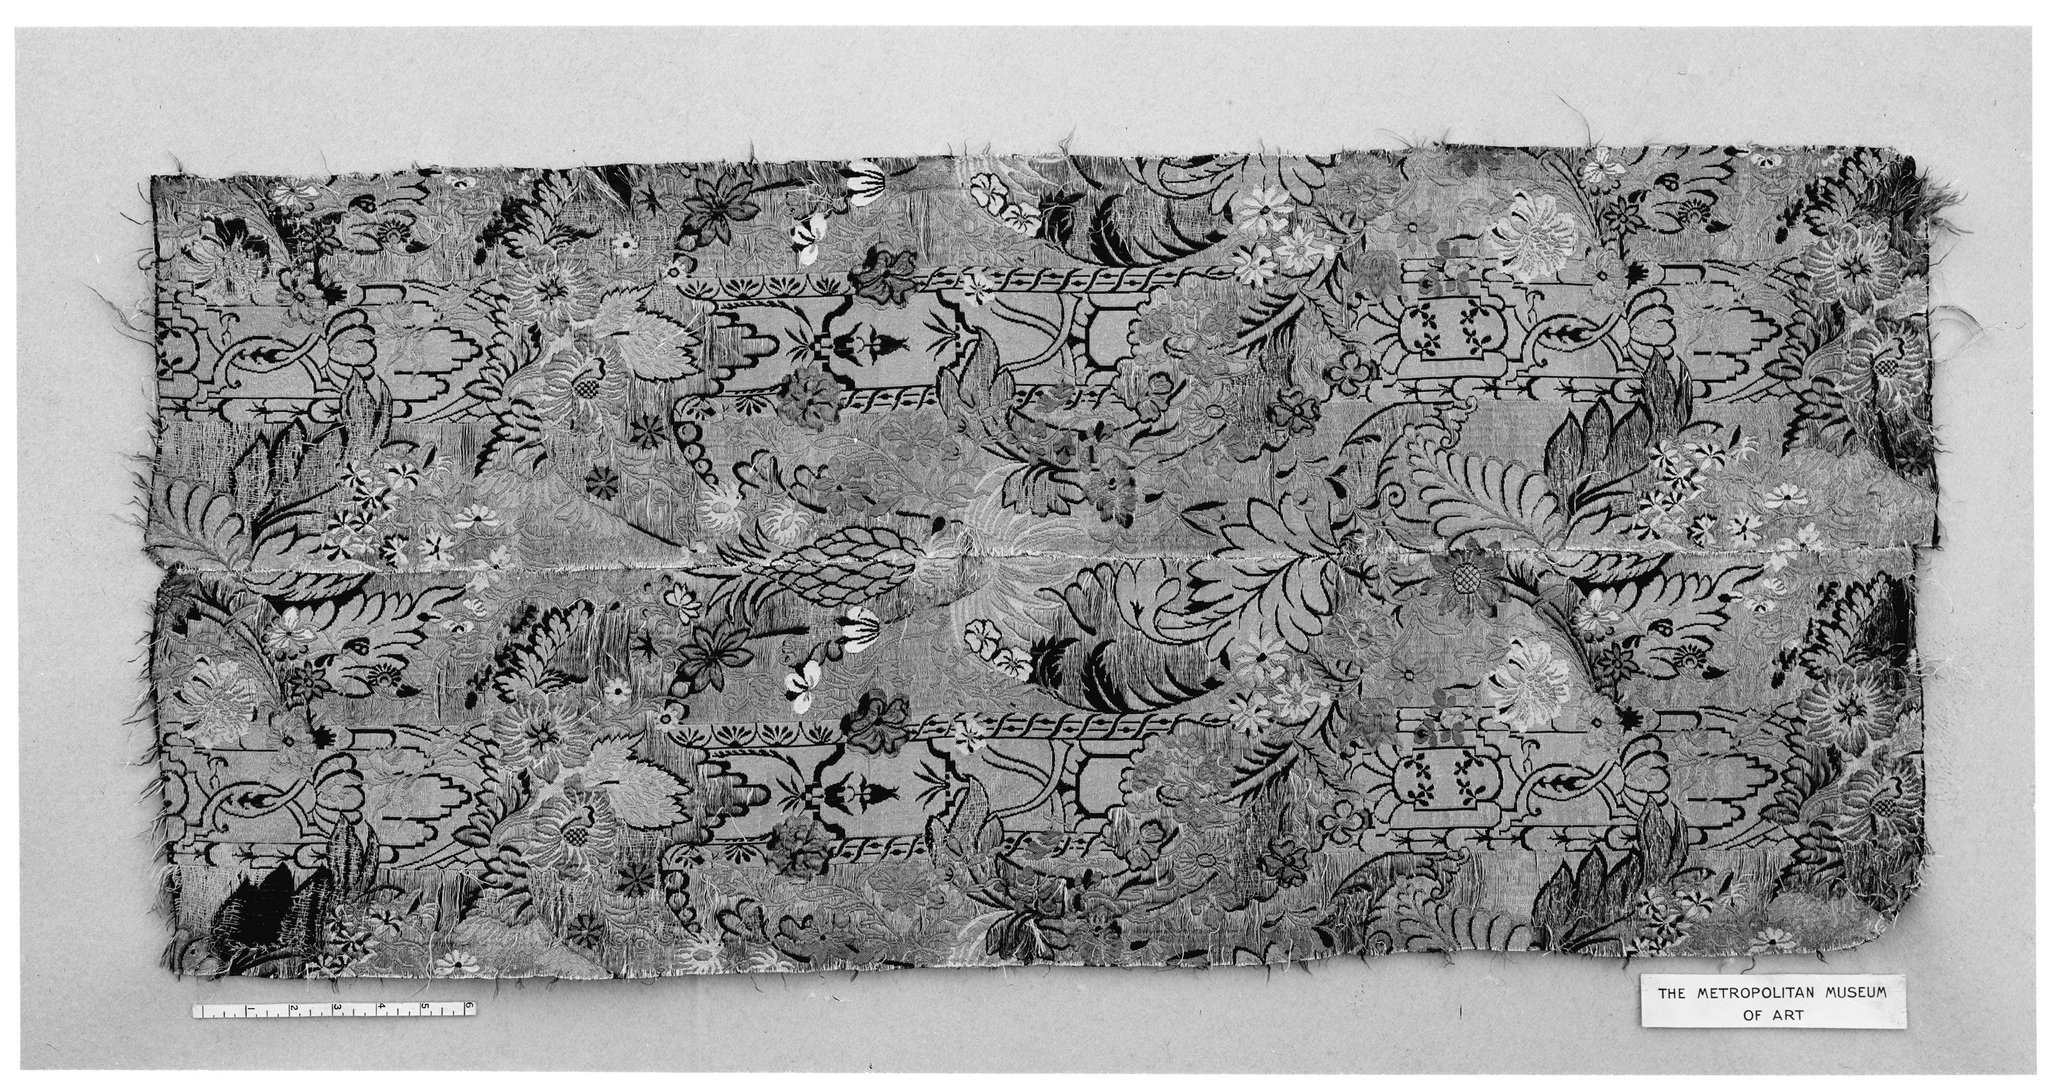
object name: piece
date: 1718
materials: metal thread, silk